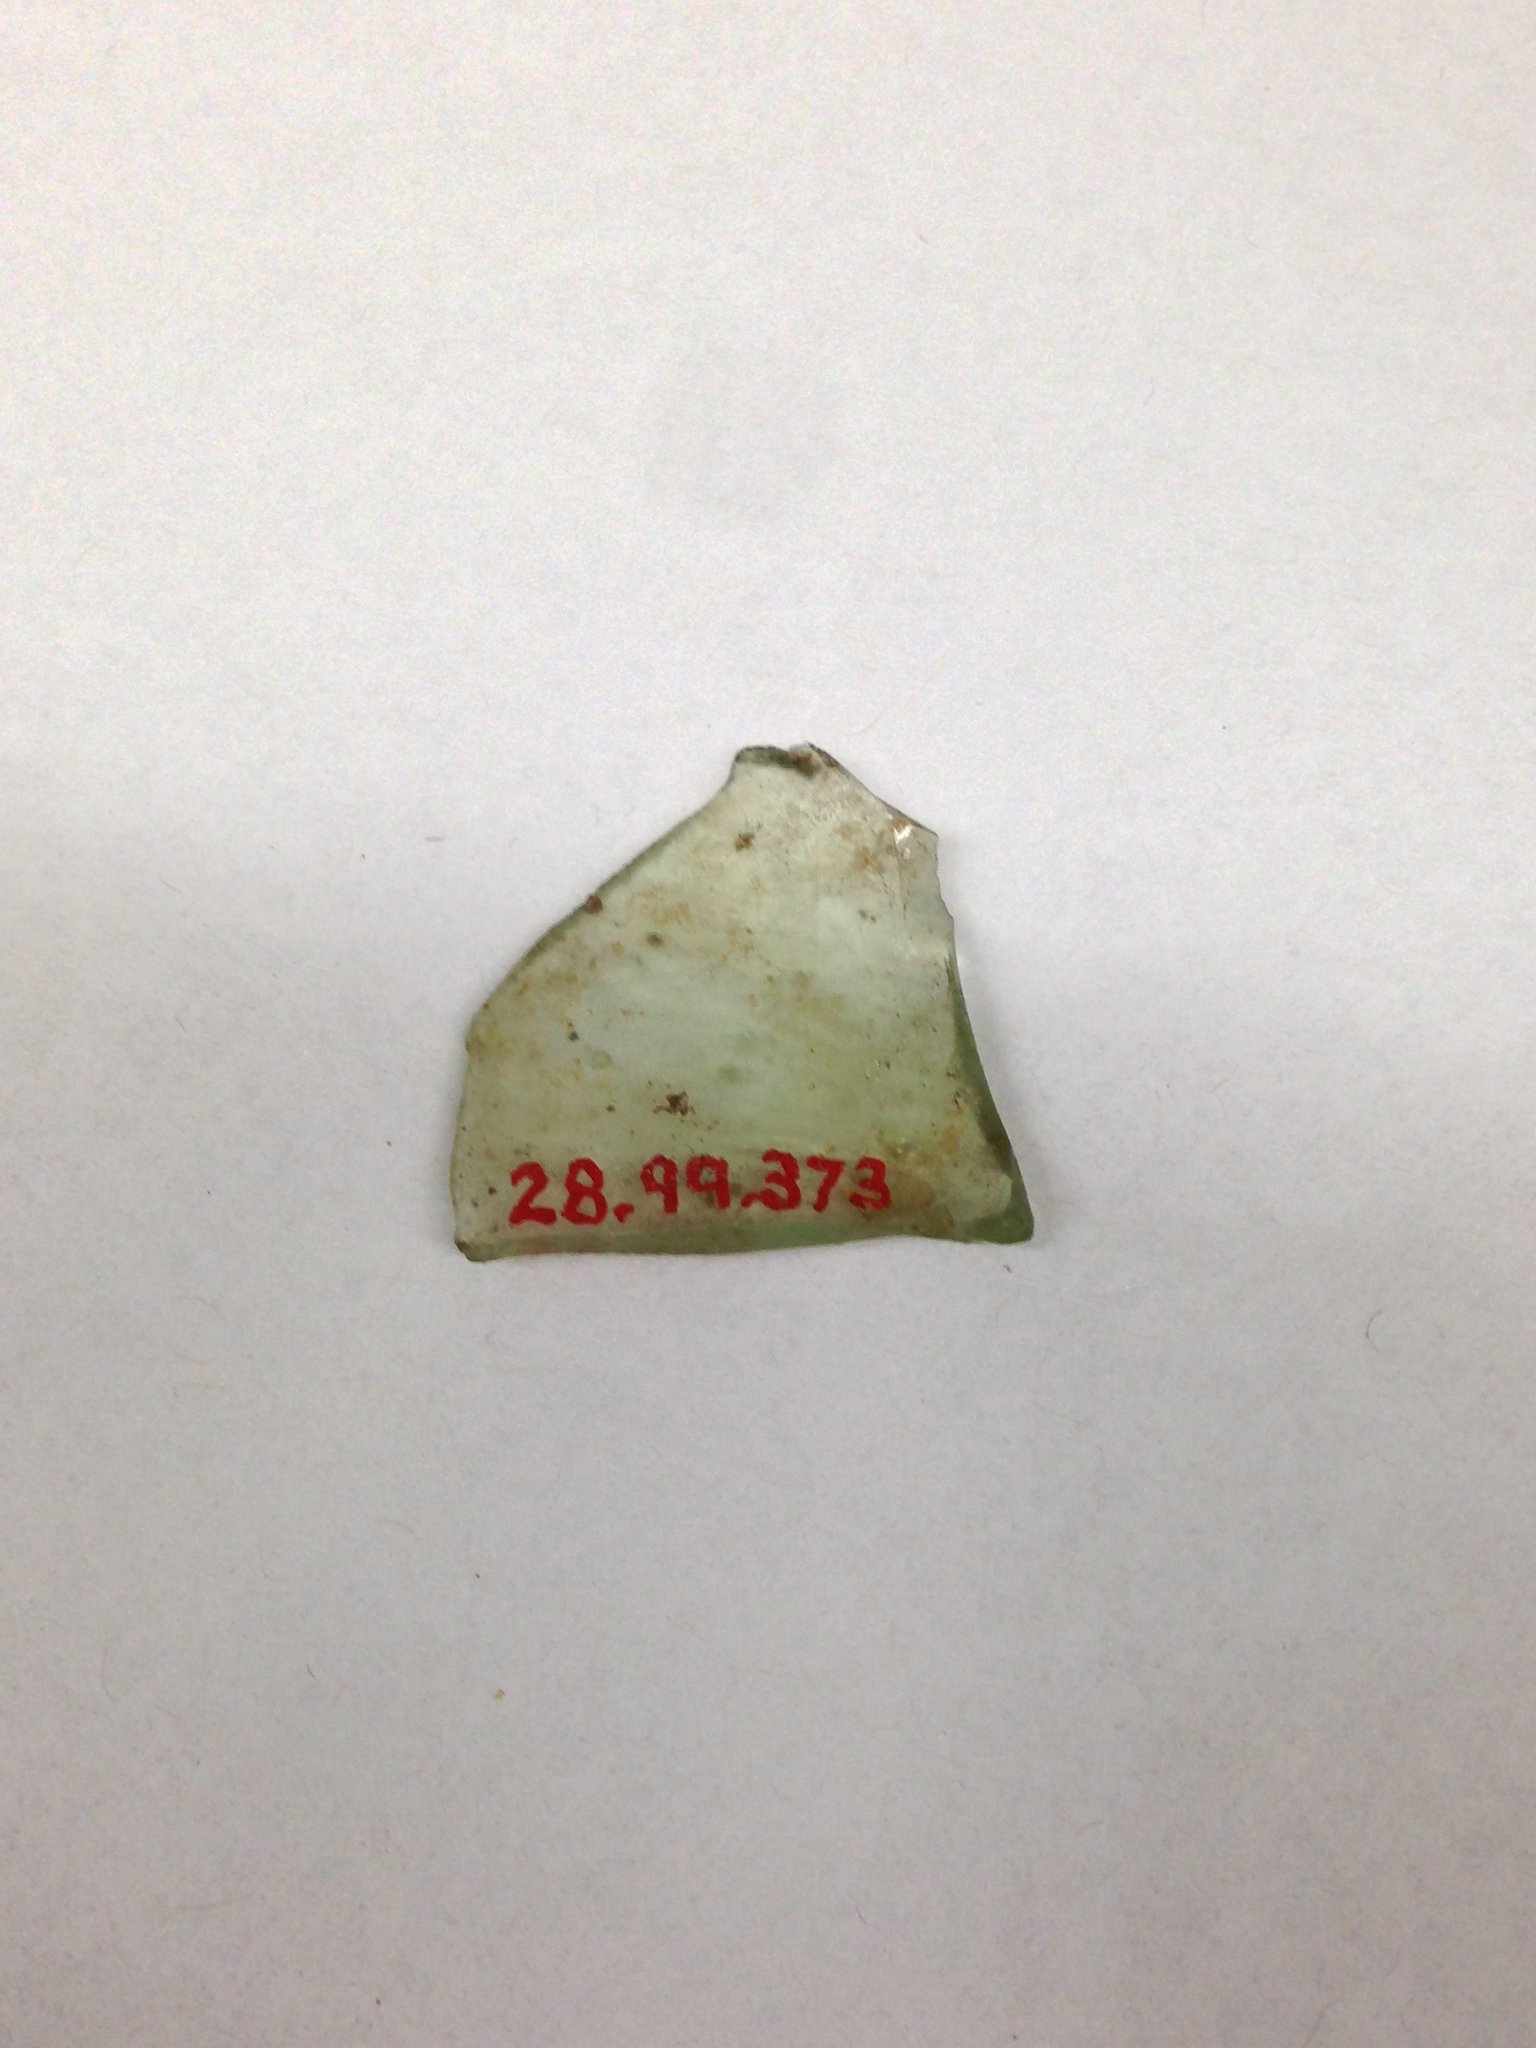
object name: fragment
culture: european or middle eastern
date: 1150-1250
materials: ceramic, glass